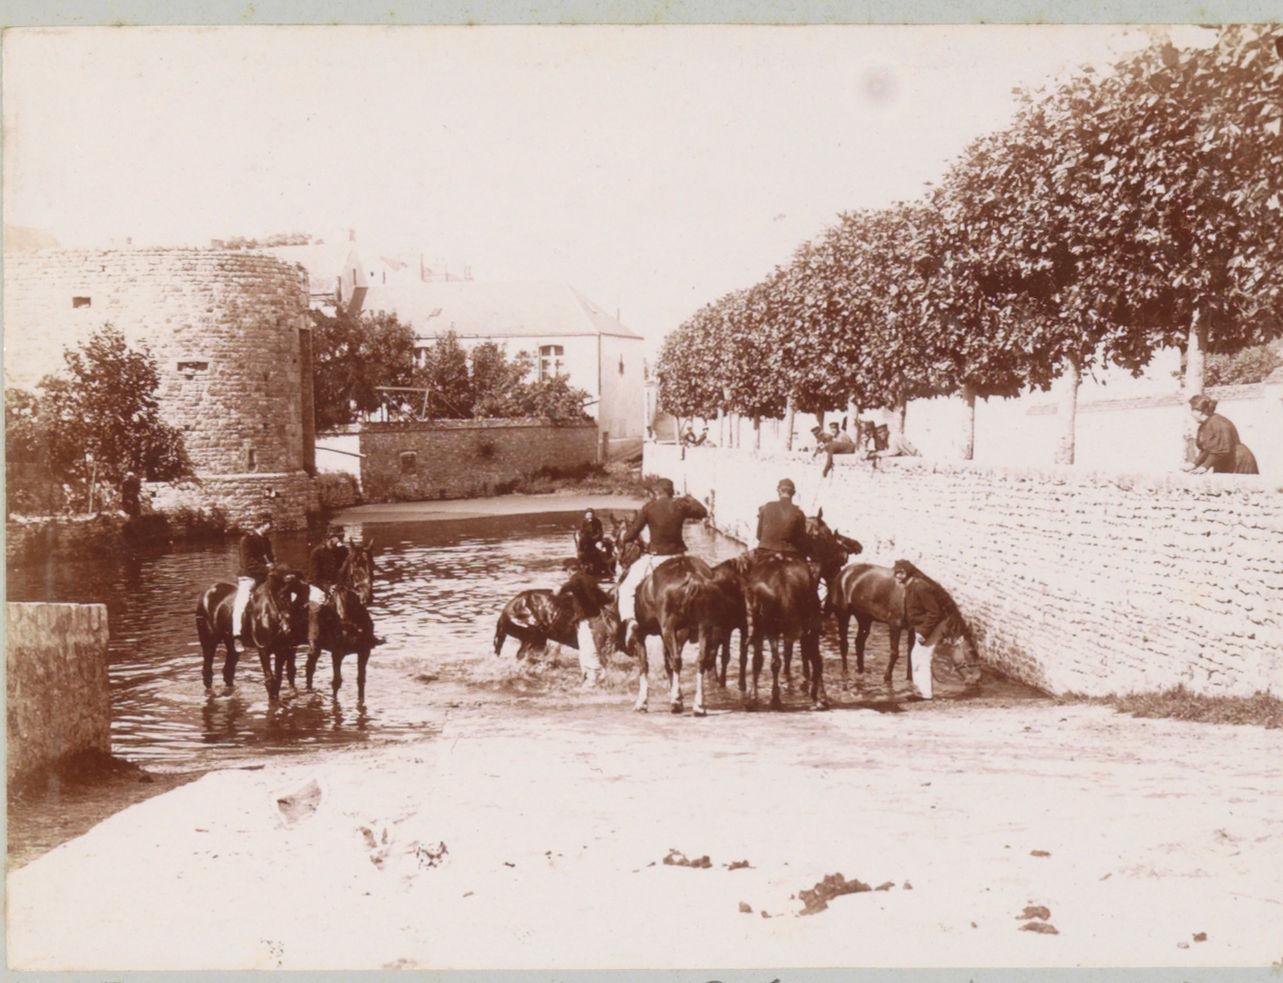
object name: photograph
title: Militairen te paard bij drenkplaats te Puiseaux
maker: delizy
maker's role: manufacturer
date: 1896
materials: paper, photographic support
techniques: gelatin silver print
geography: puiseaux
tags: land forces (+ cavalry, horsemen), watering-place, spa, giving water, feeding (cattle)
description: Onderdeel van Fotoalbum van een Franse amateurfotograaf met opnames van uitstapjes in Frankrijk, Spanje, België, Luxemburg en Nederland, de eerste automobielen en autoraces.